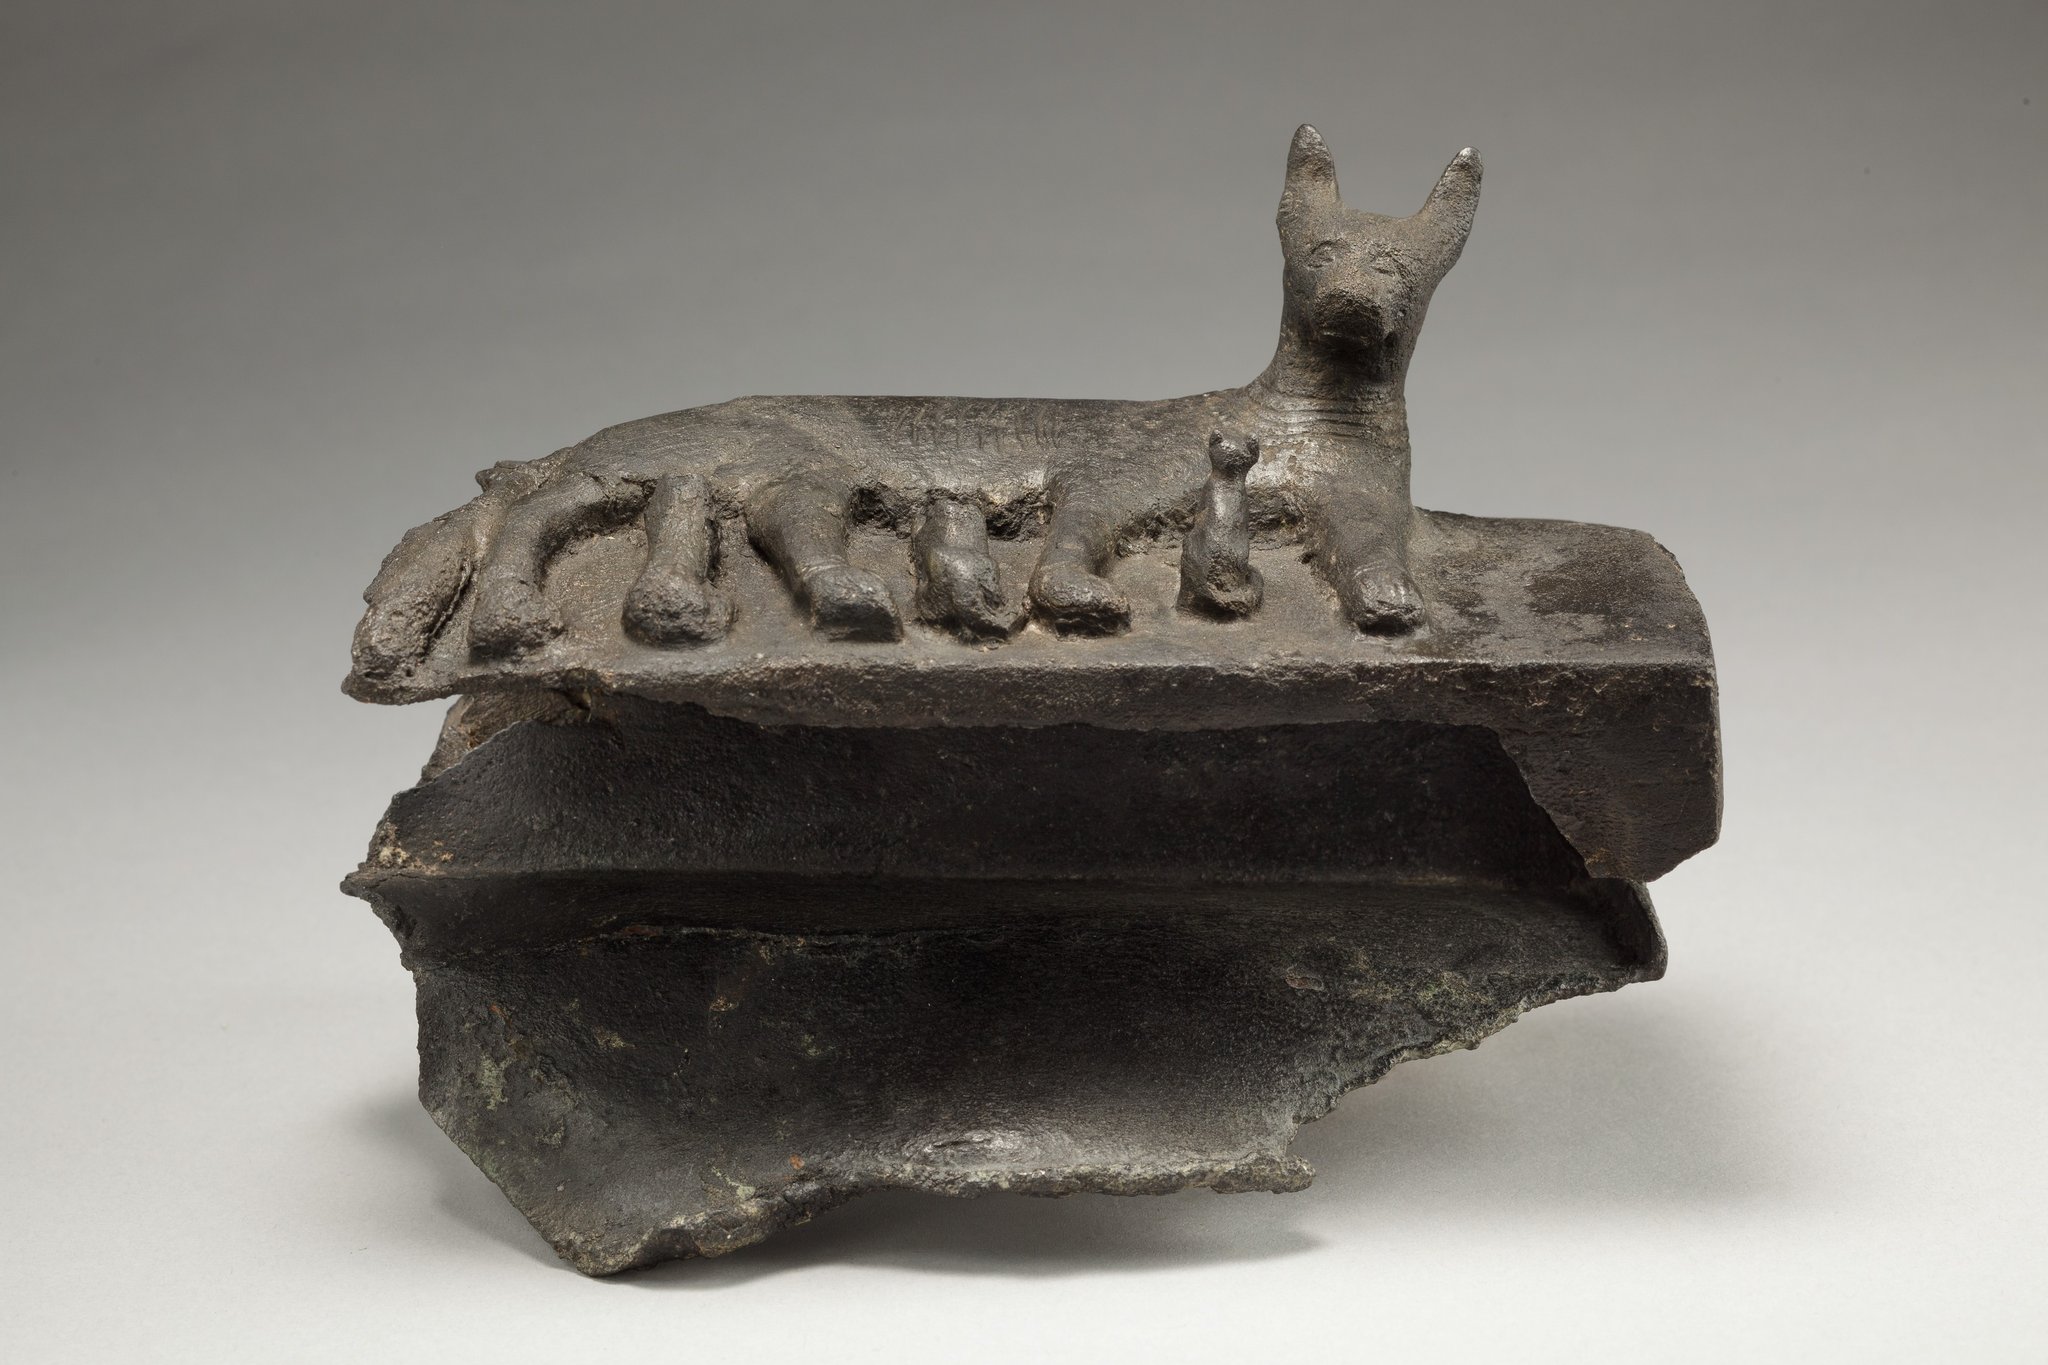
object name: figurine group, cat with kitten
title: Cat with kittens on damaged box for animal mummy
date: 664-630 BCE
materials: metal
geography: egypt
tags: cats